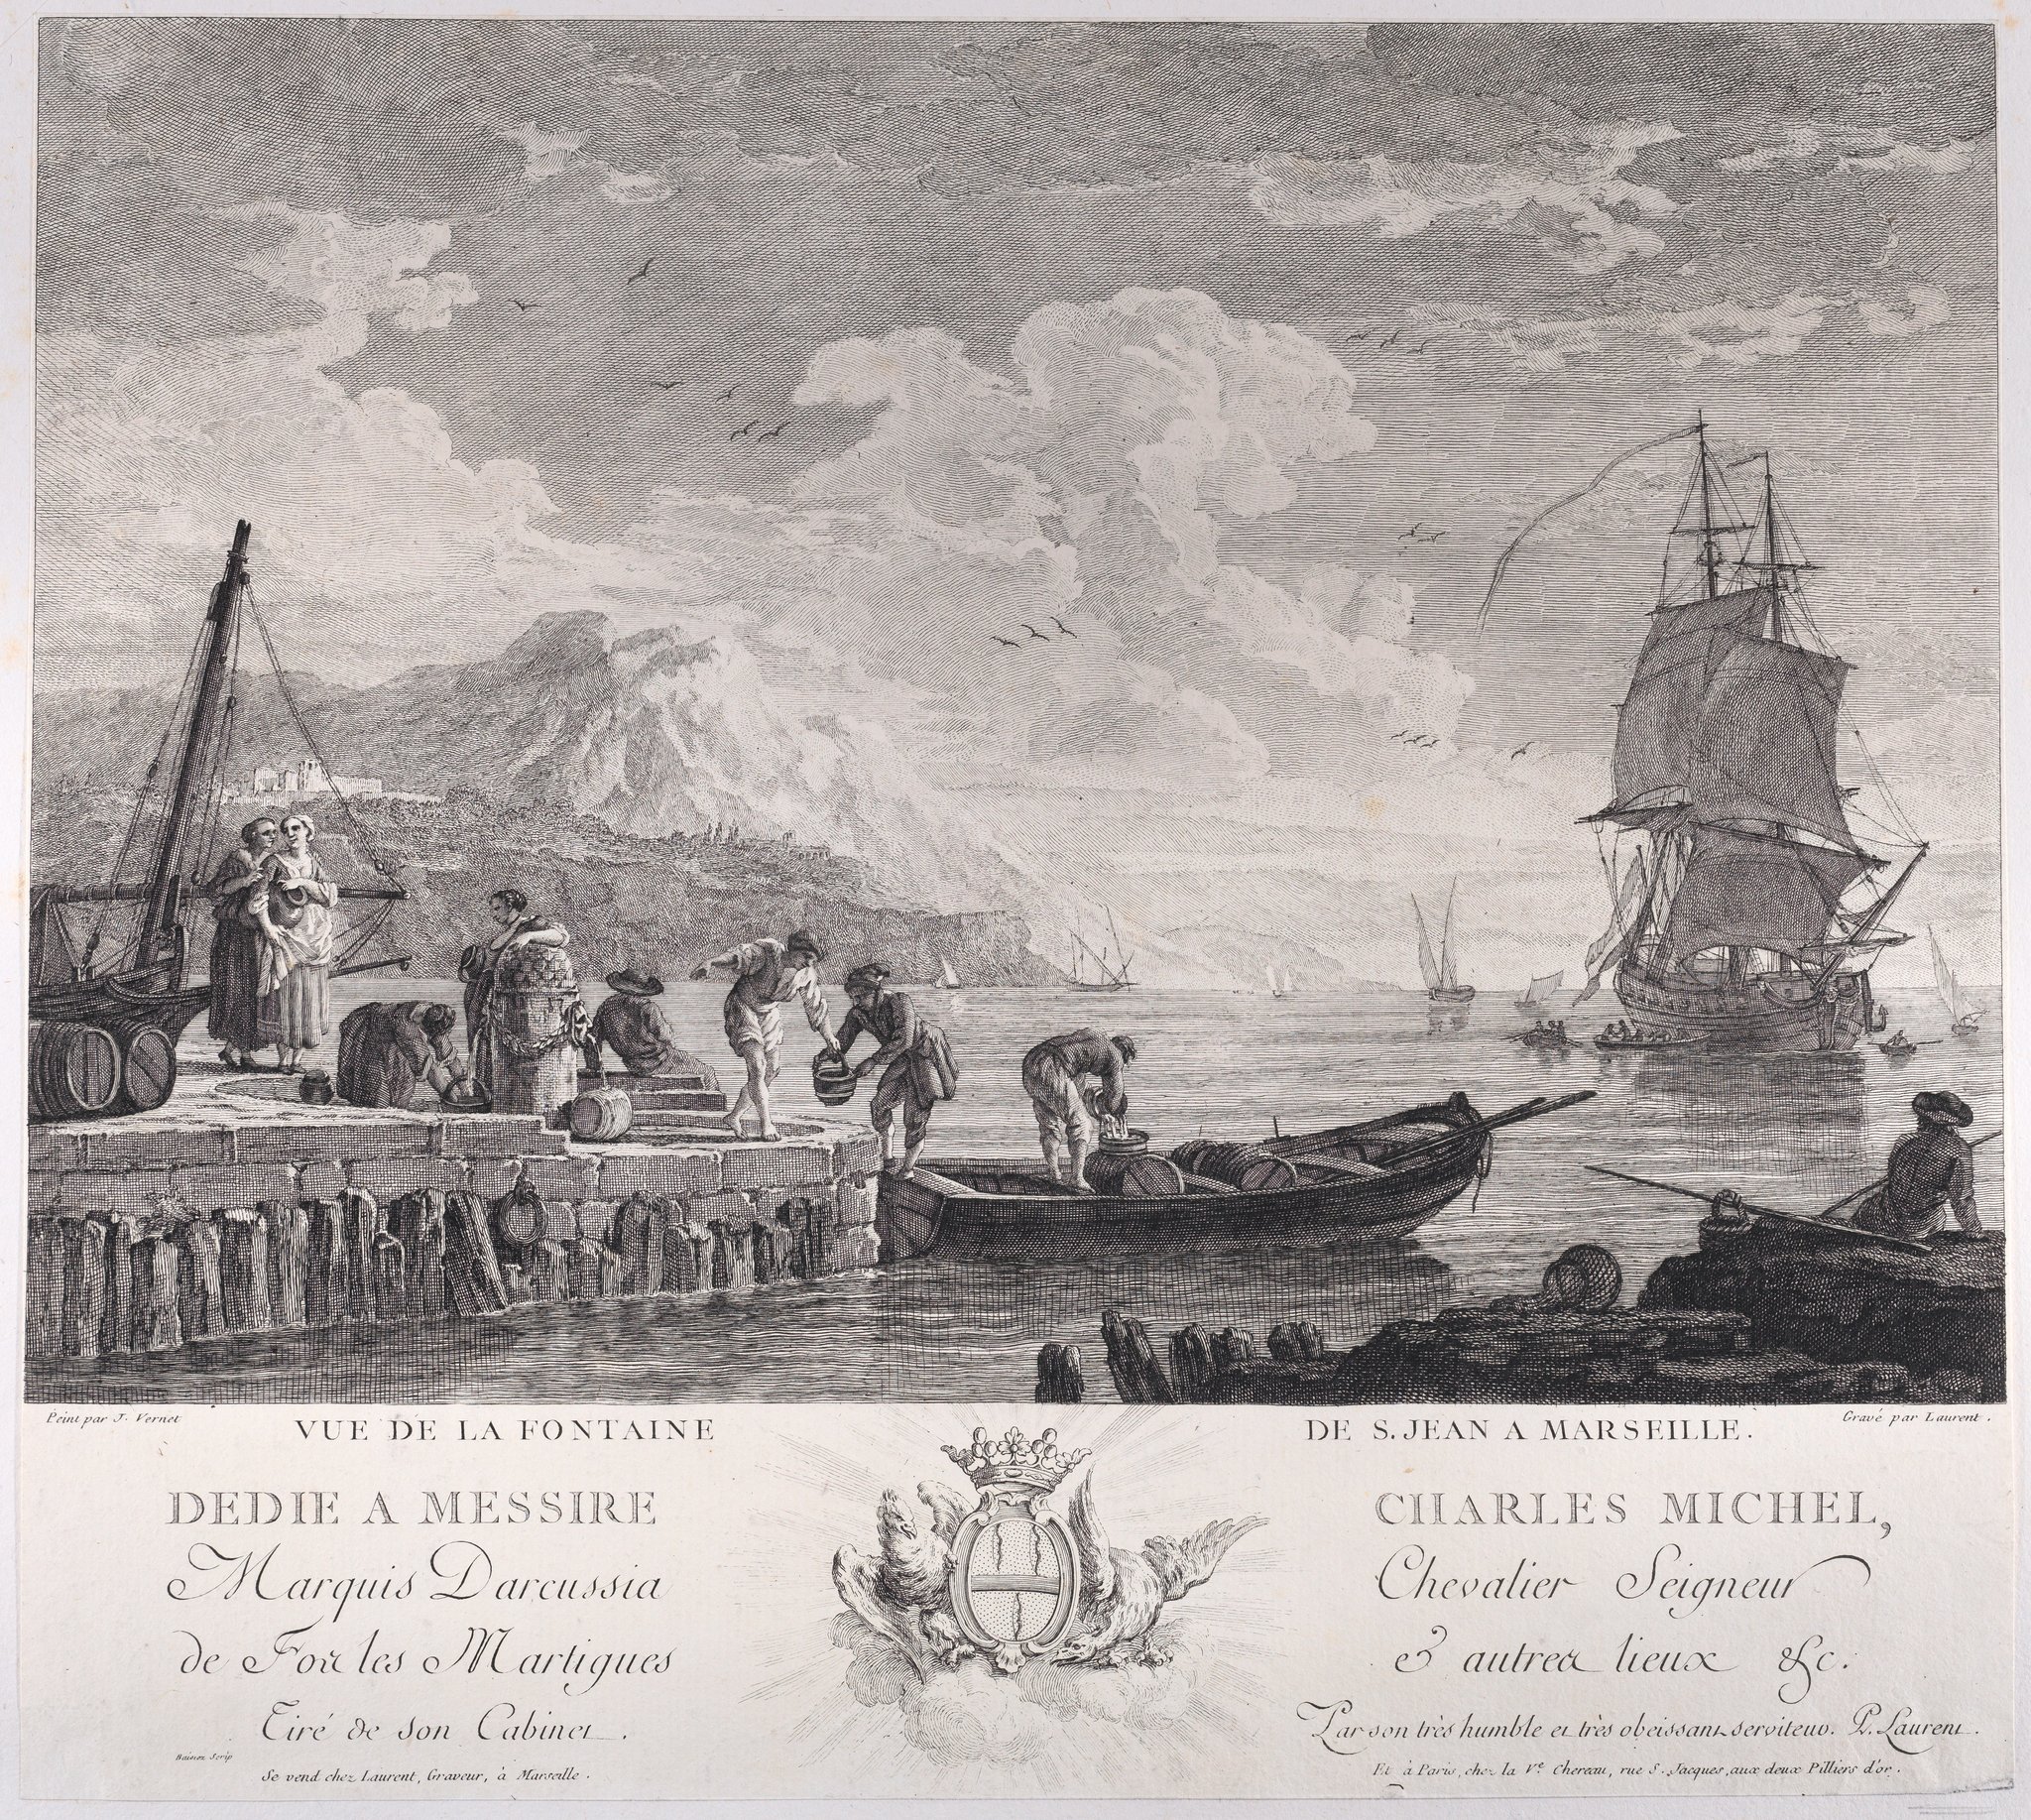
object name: print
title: View of the Fountain of St. John in Marseille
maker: joseph vernet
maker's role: artist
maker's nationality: french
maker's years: 1714-1789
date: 1750-1800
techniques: engraving